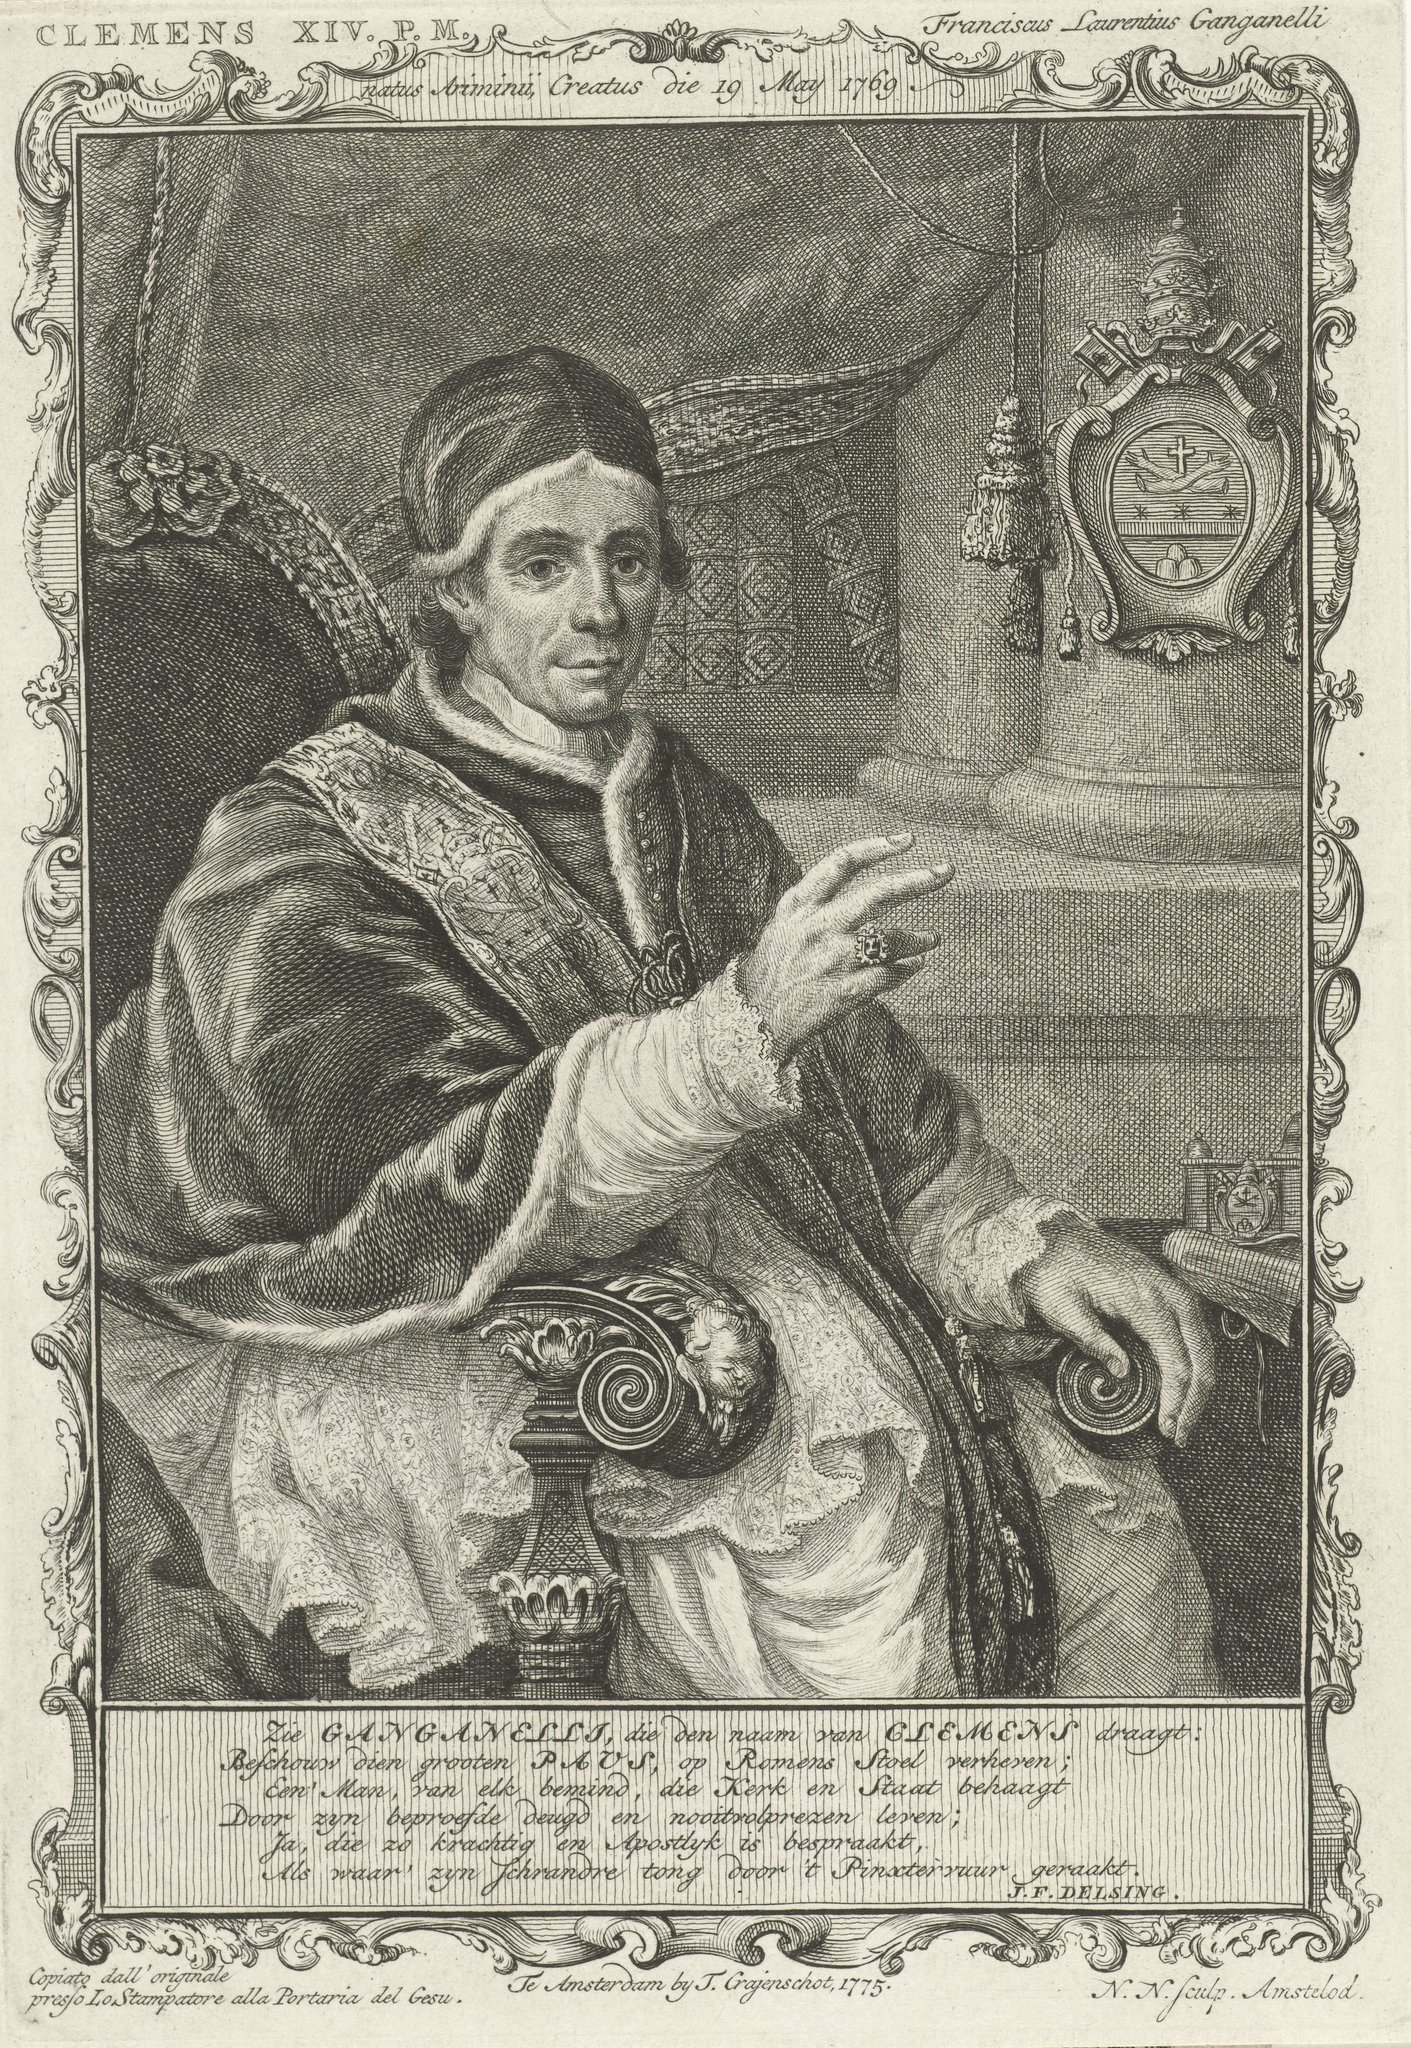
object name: print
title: Clemens XIV. P.M.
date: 1775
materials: paper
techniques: etching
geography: amsterdam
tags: pope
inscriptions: collector's mark: Lugt 2228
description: Paus Clemens XIV gehuld in pauselijk gewaad, het hoofd getooid met een camauro, zittend in een leunstoel. Met zijn rechterhand maakt hij een zegenend gebaar. Rechts op de achtergrond hangt het wapenschild van Clemens XIV aan een pilaar. Onder de voorstelling staat een zesregelige tekst in het Nederlands.